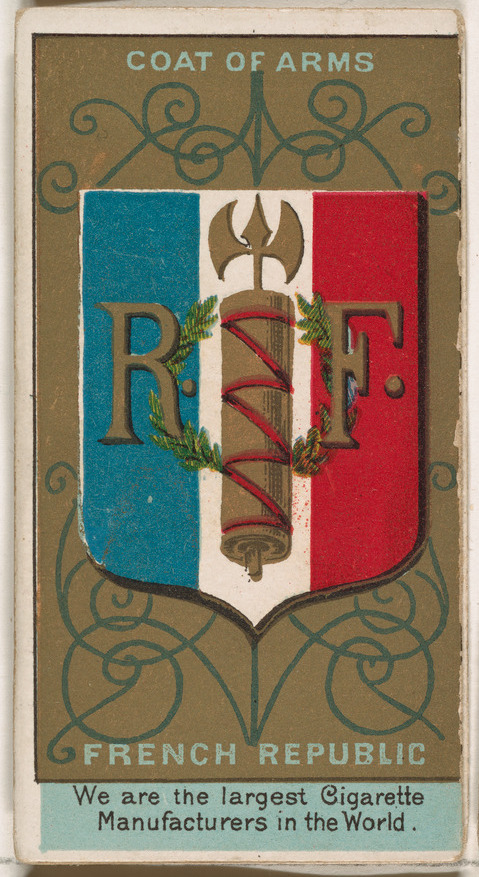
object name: print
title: President Sadi-Carnot of France, from the Rulers, Flags, and Coats of Arms series (N126-2) issued by W. Duke, Sons & Co.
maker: w. duke, sons & co.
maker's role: publisher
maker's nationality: american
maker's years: 1870-1920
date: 1888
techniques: color lithograph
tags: men,portraits,coat of arms,flags